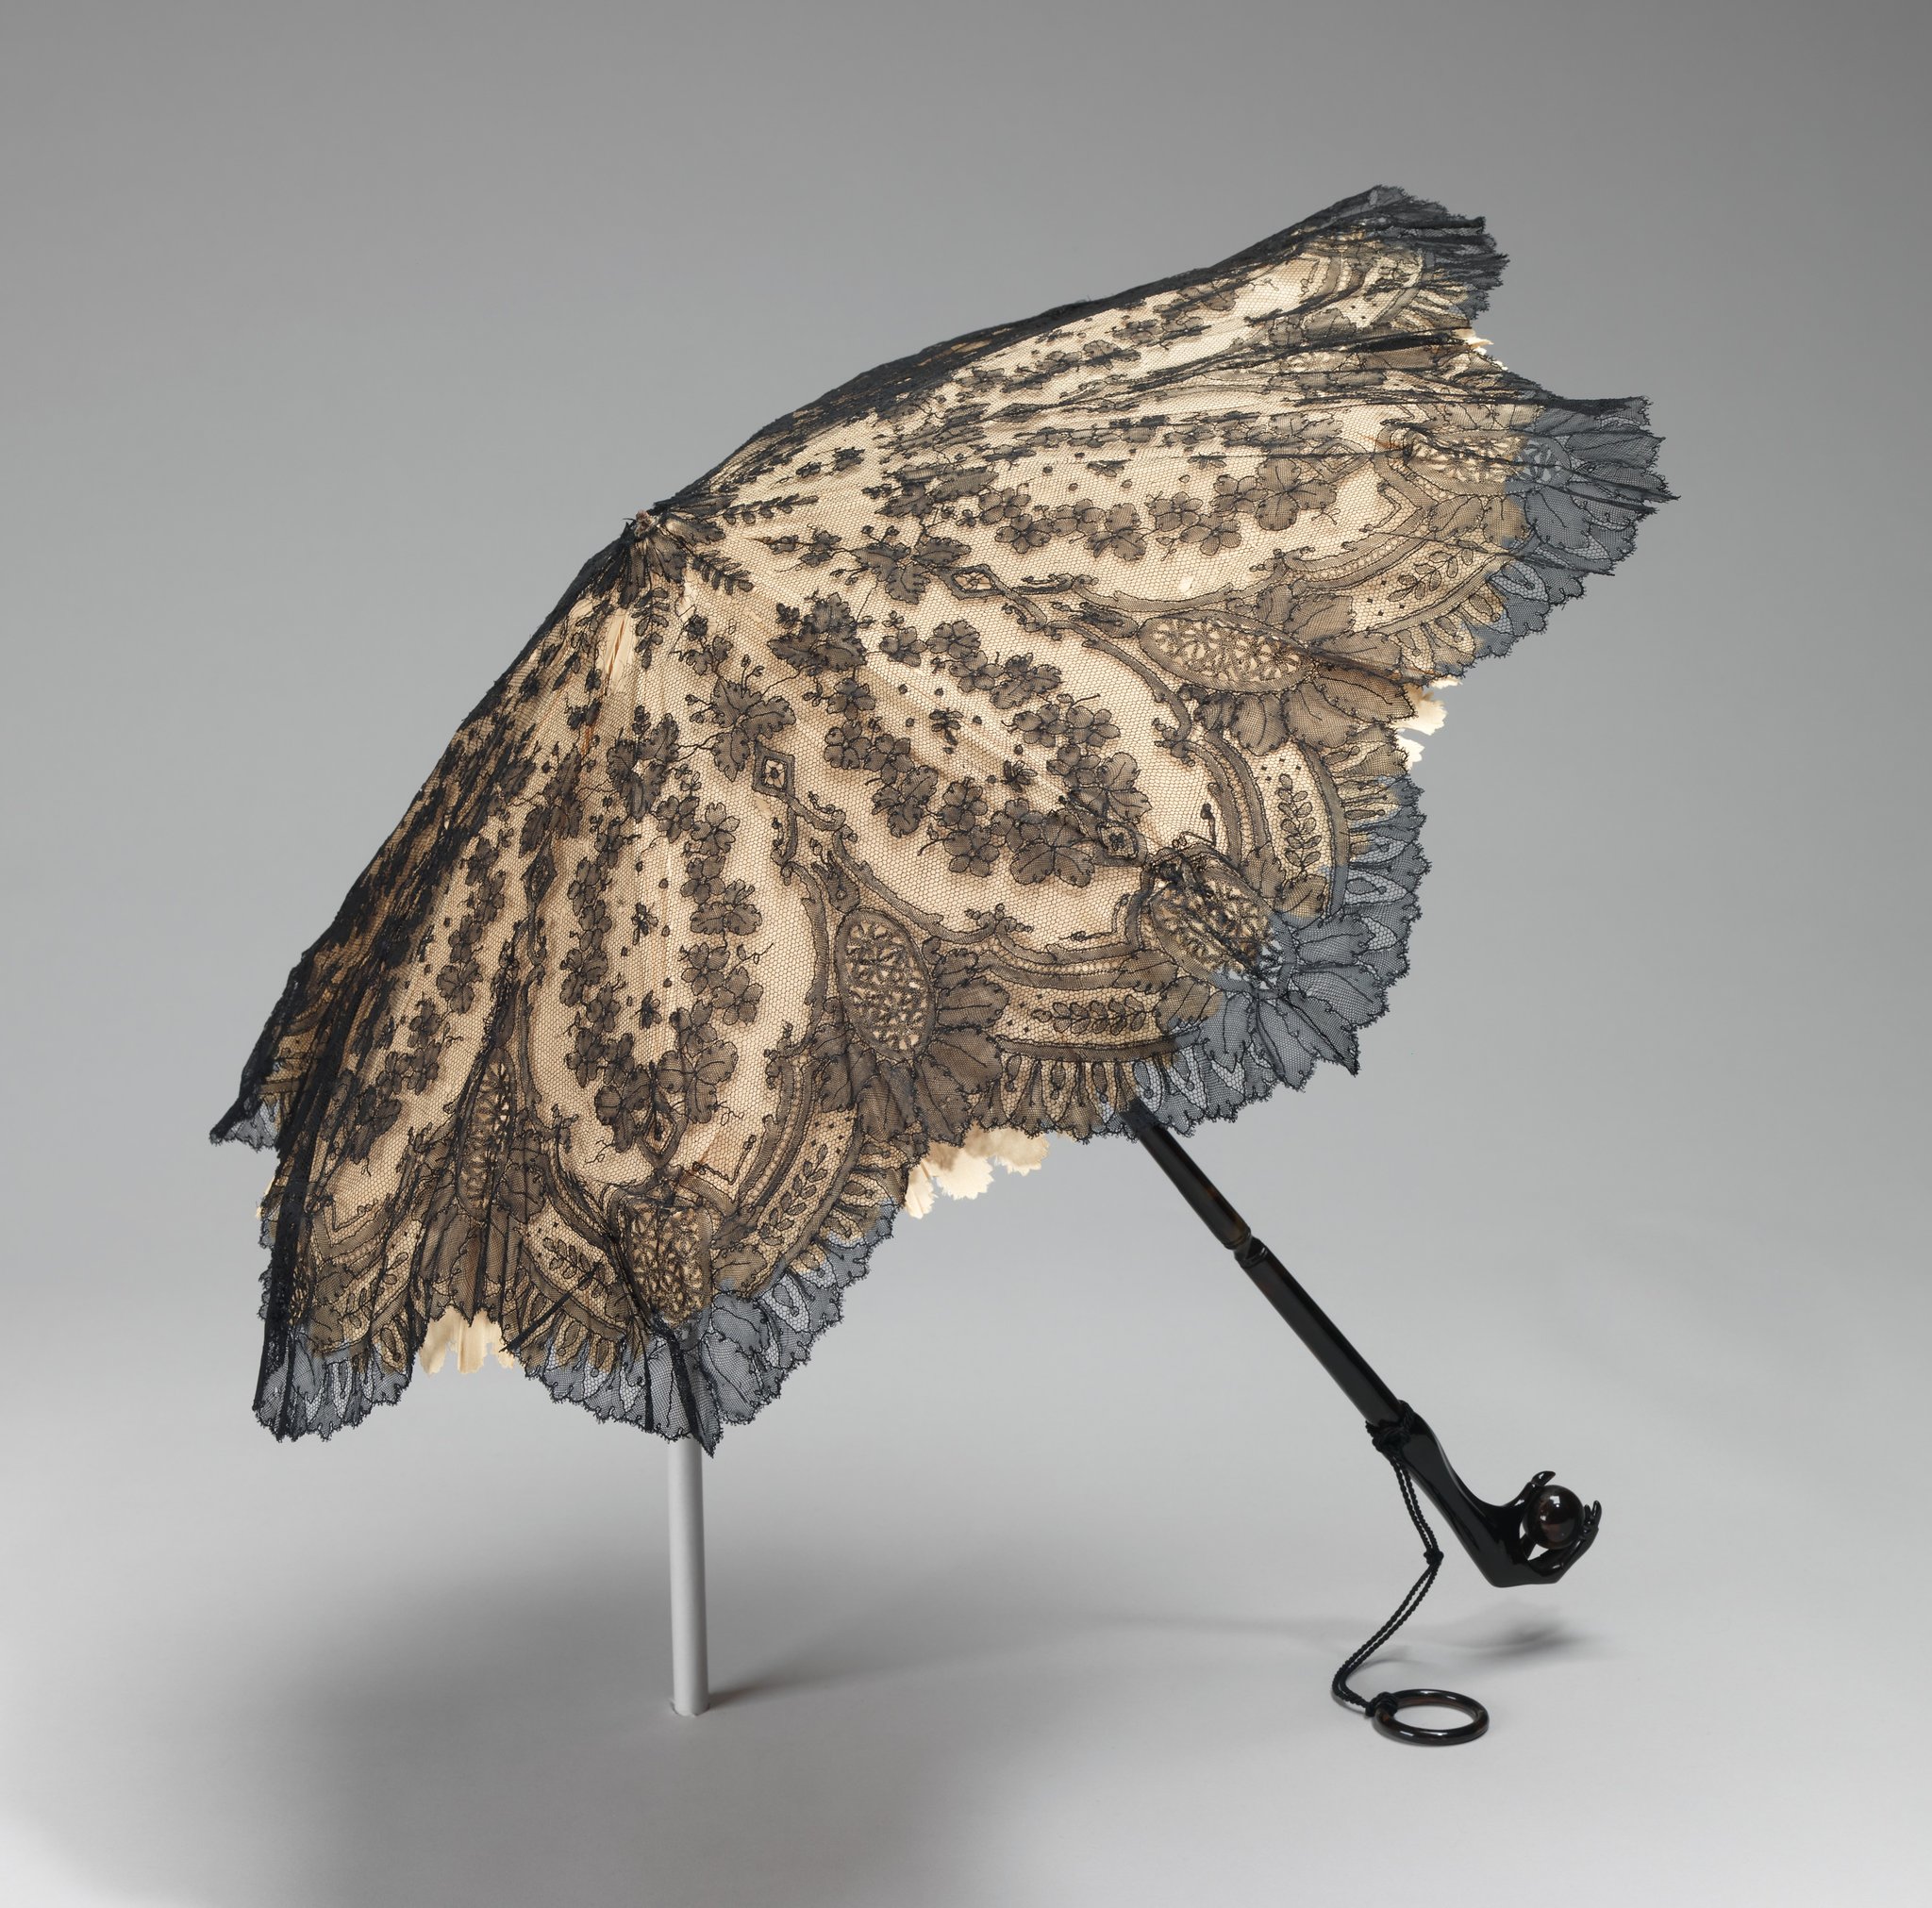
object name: parasol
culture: american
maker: fortis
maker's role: manufacturer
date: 1860-1865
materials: metal, silk, shell, wood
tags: flowers